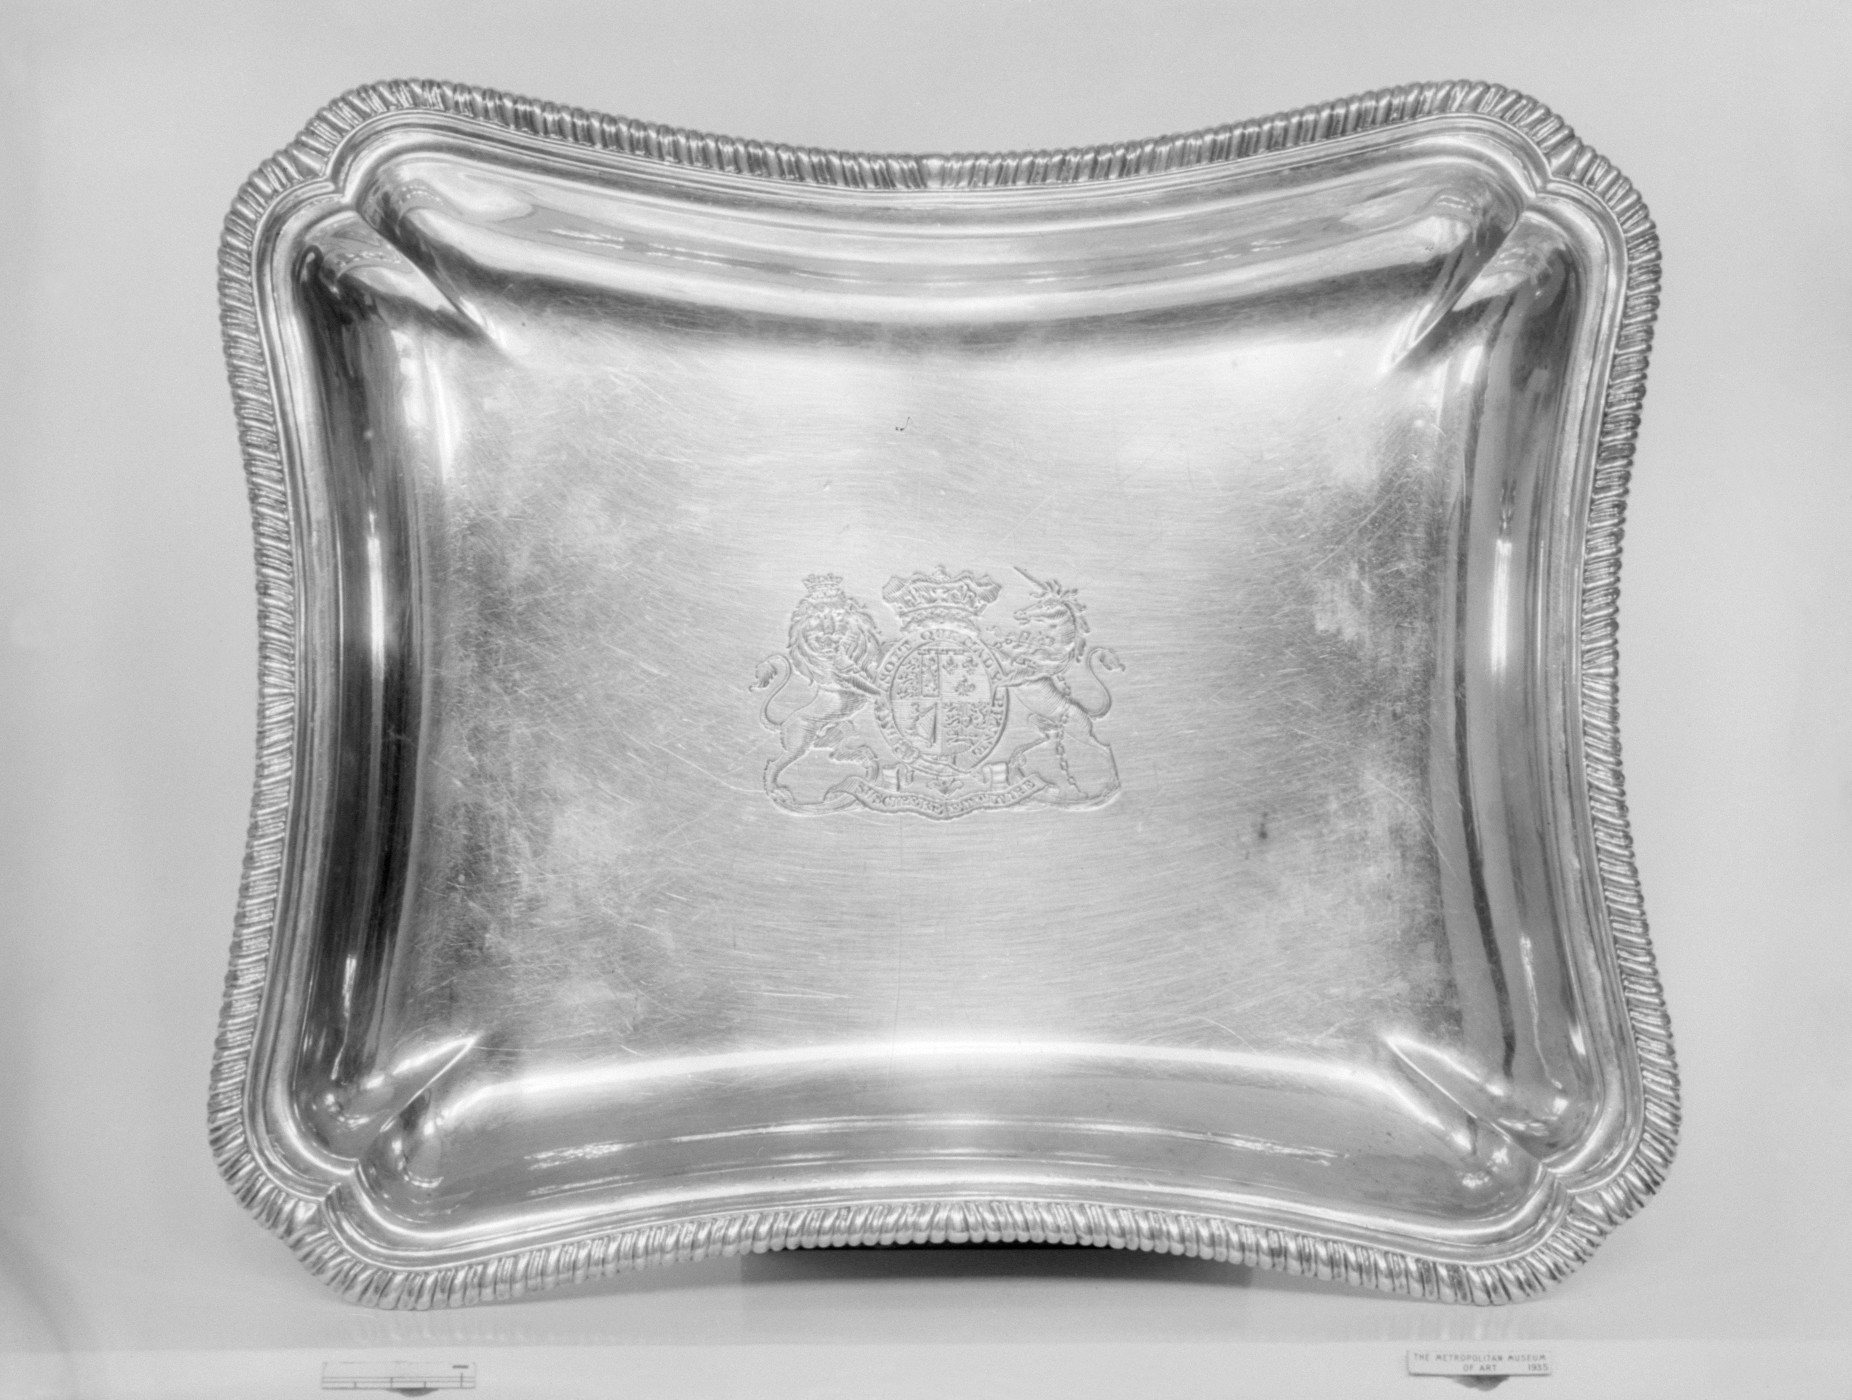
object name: dish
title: Compote dish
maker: thomas heming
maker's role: maker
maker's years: 1745-1773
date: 1770-1771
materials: silver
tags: coat of arms